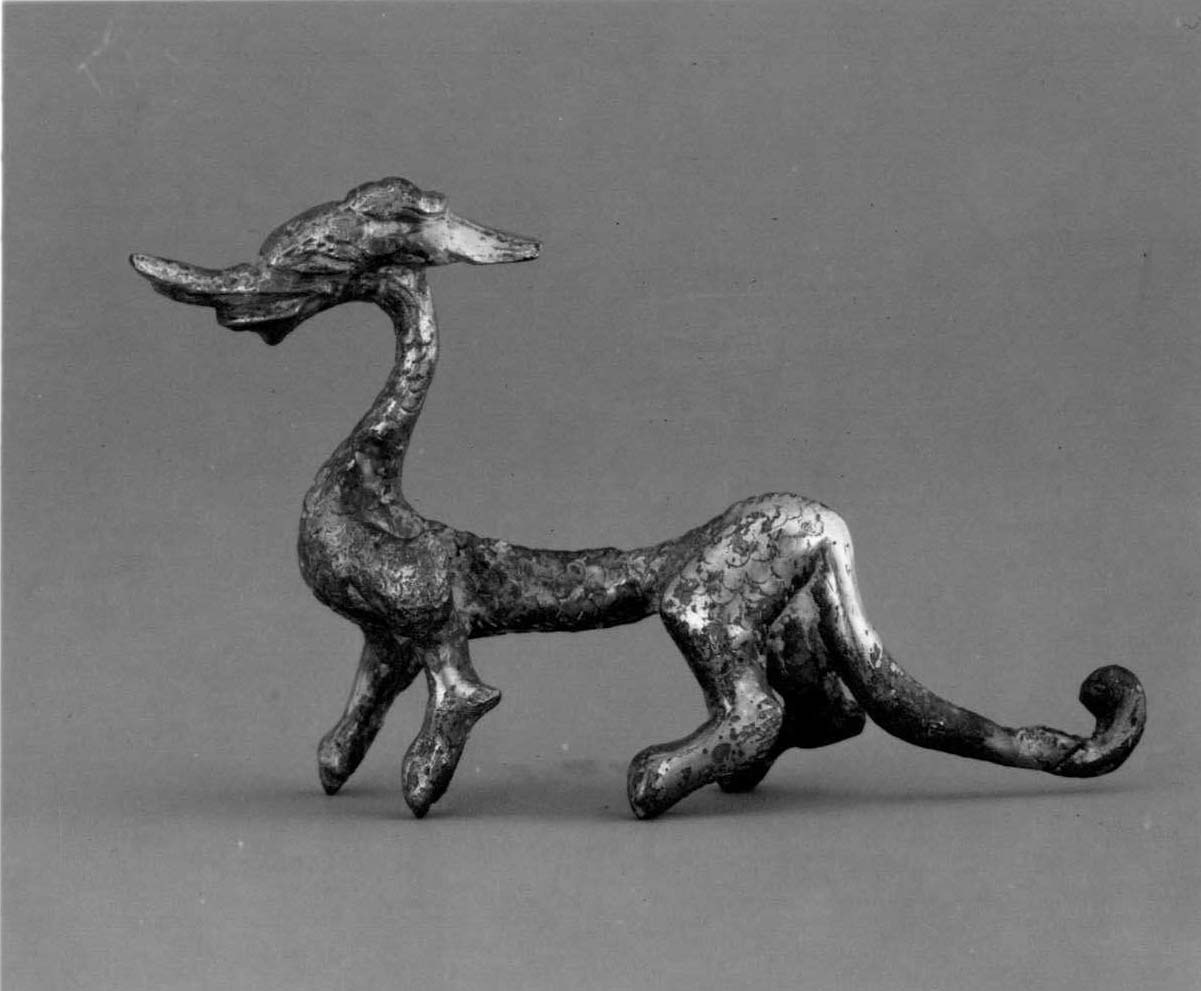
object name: figure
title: Dragon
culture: chinese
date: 601-700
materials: gilt bronze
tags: dragons